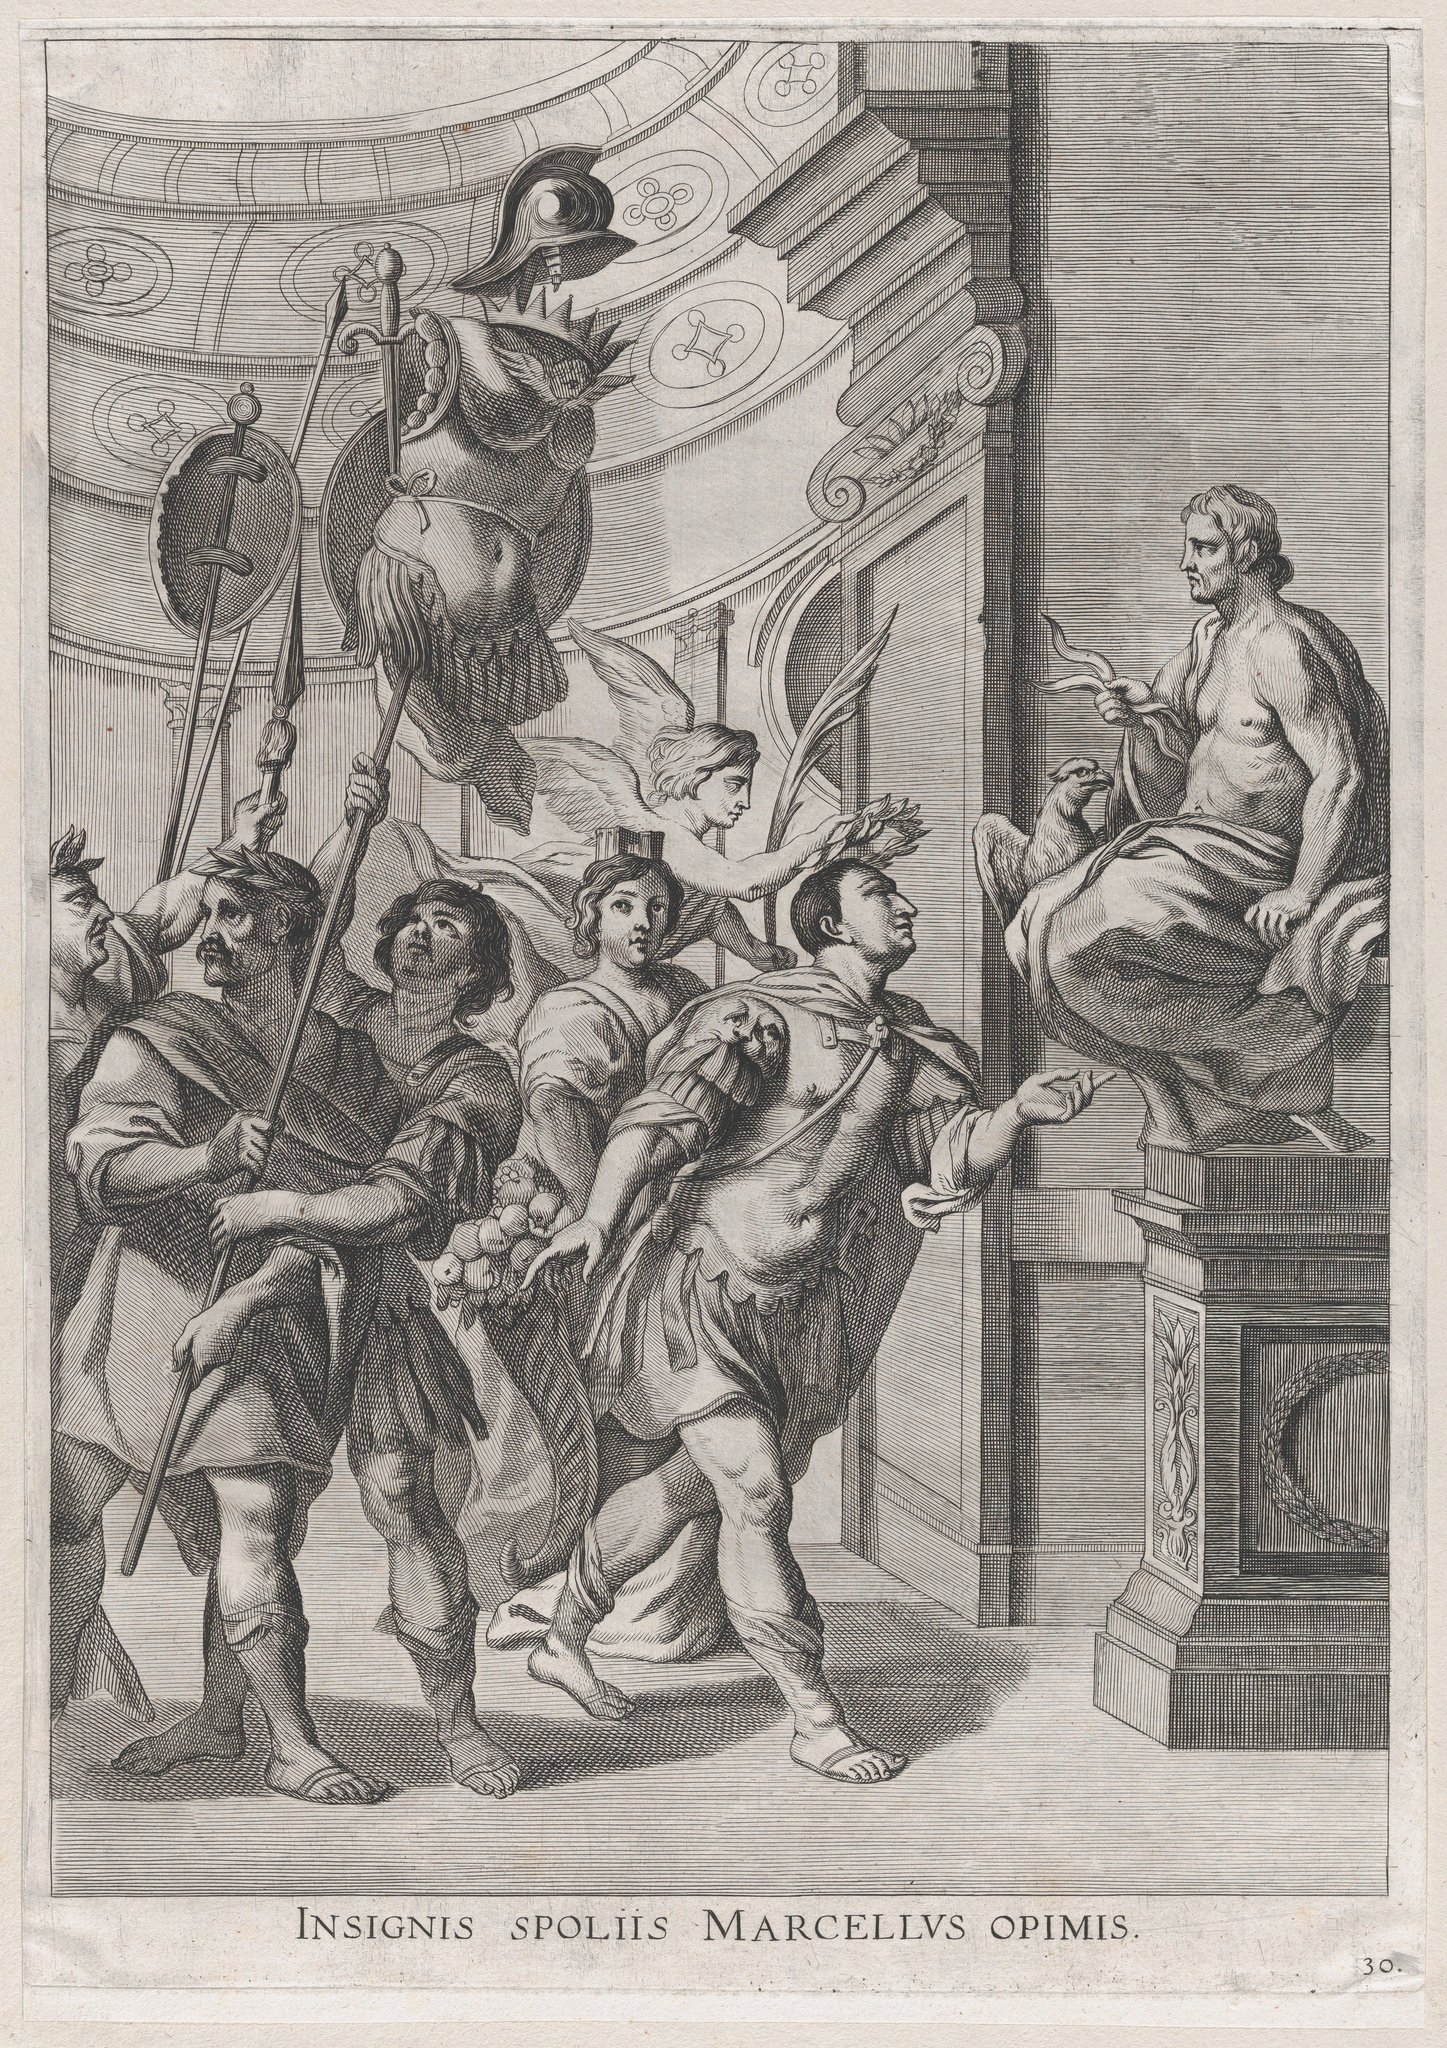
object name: print, fete, ornament architecture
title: Plate 30: Marcellus dedicating the spoils of war to Jupiter; from Guillielmus Becanus's 'Serenissimi Principis Ferdinandi, Hispaniarum Infantis...'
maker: johannes meursius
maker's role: publisher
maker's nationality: flemish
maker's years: 1600-1699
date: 1636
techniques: engraving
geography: antwerp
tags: armor,weapons,men,jupiter